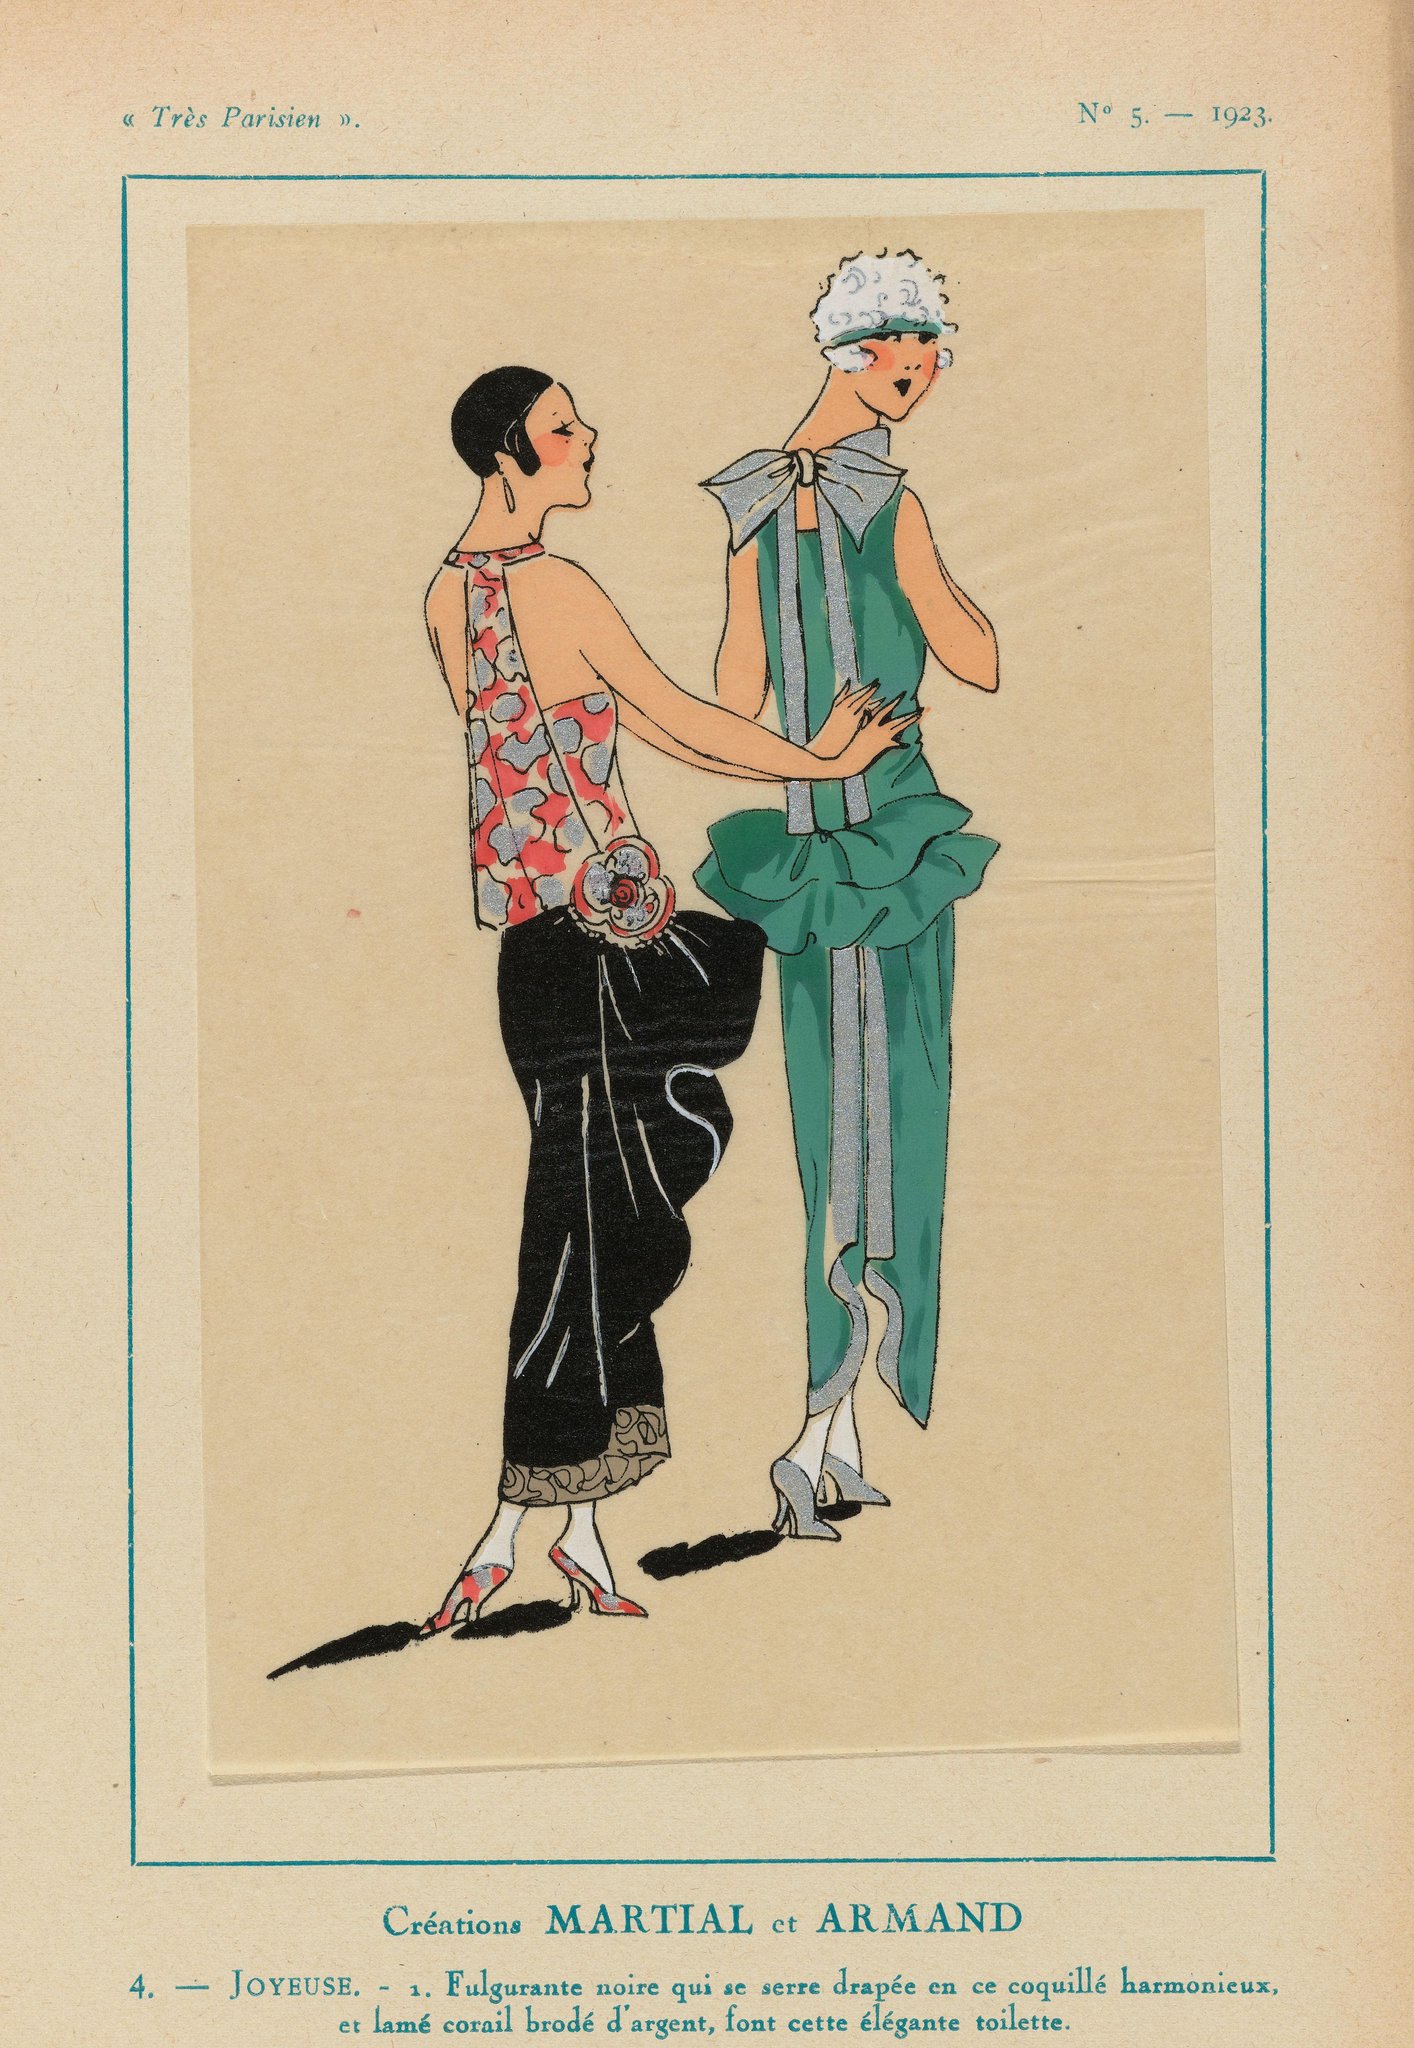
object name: fashion print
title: Très Parisien, 1923, No 5: 4.- JOYEUSE. -1. Fulgurante noire...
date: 1923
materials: paper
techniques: hand coloring, letterpress printing, lithography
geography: paris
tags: diadem, tiara (+ women's clothes), embroidery with beads (+ women's clothes), fashion plates, dress, gown (+ women's clothes)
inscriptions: title: ‘Très Parisien / No 5. - 1923’, caption: ‘Créations MARTIAL et ARMAND. / 4. - JOYEUSE. - 1. Fulgurante noire qui se serre drapée en ce coquillé harmonieux, et lamé corail brodé d'argent, font cette élégante toilette. CHANTECLAIR. - 2. Quel heureux 1860 rajeuni à la manière de 1923, pour cette robe de moire satinée brodée de fils de perles.’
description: Ontwerpen van Martial et Armand. 1. Elegant 'toilette' met zwarte glimmende rok aan één zijde gedrapeerd en lijfje van koraalkleurige lamé geborduurd in zilver. 2. Jurk van 'moire satinée' geborduurd met 'fils de perles' (kralensnoeren?). Prent uit het modetijdschrift Très Parisien (1920-1936).